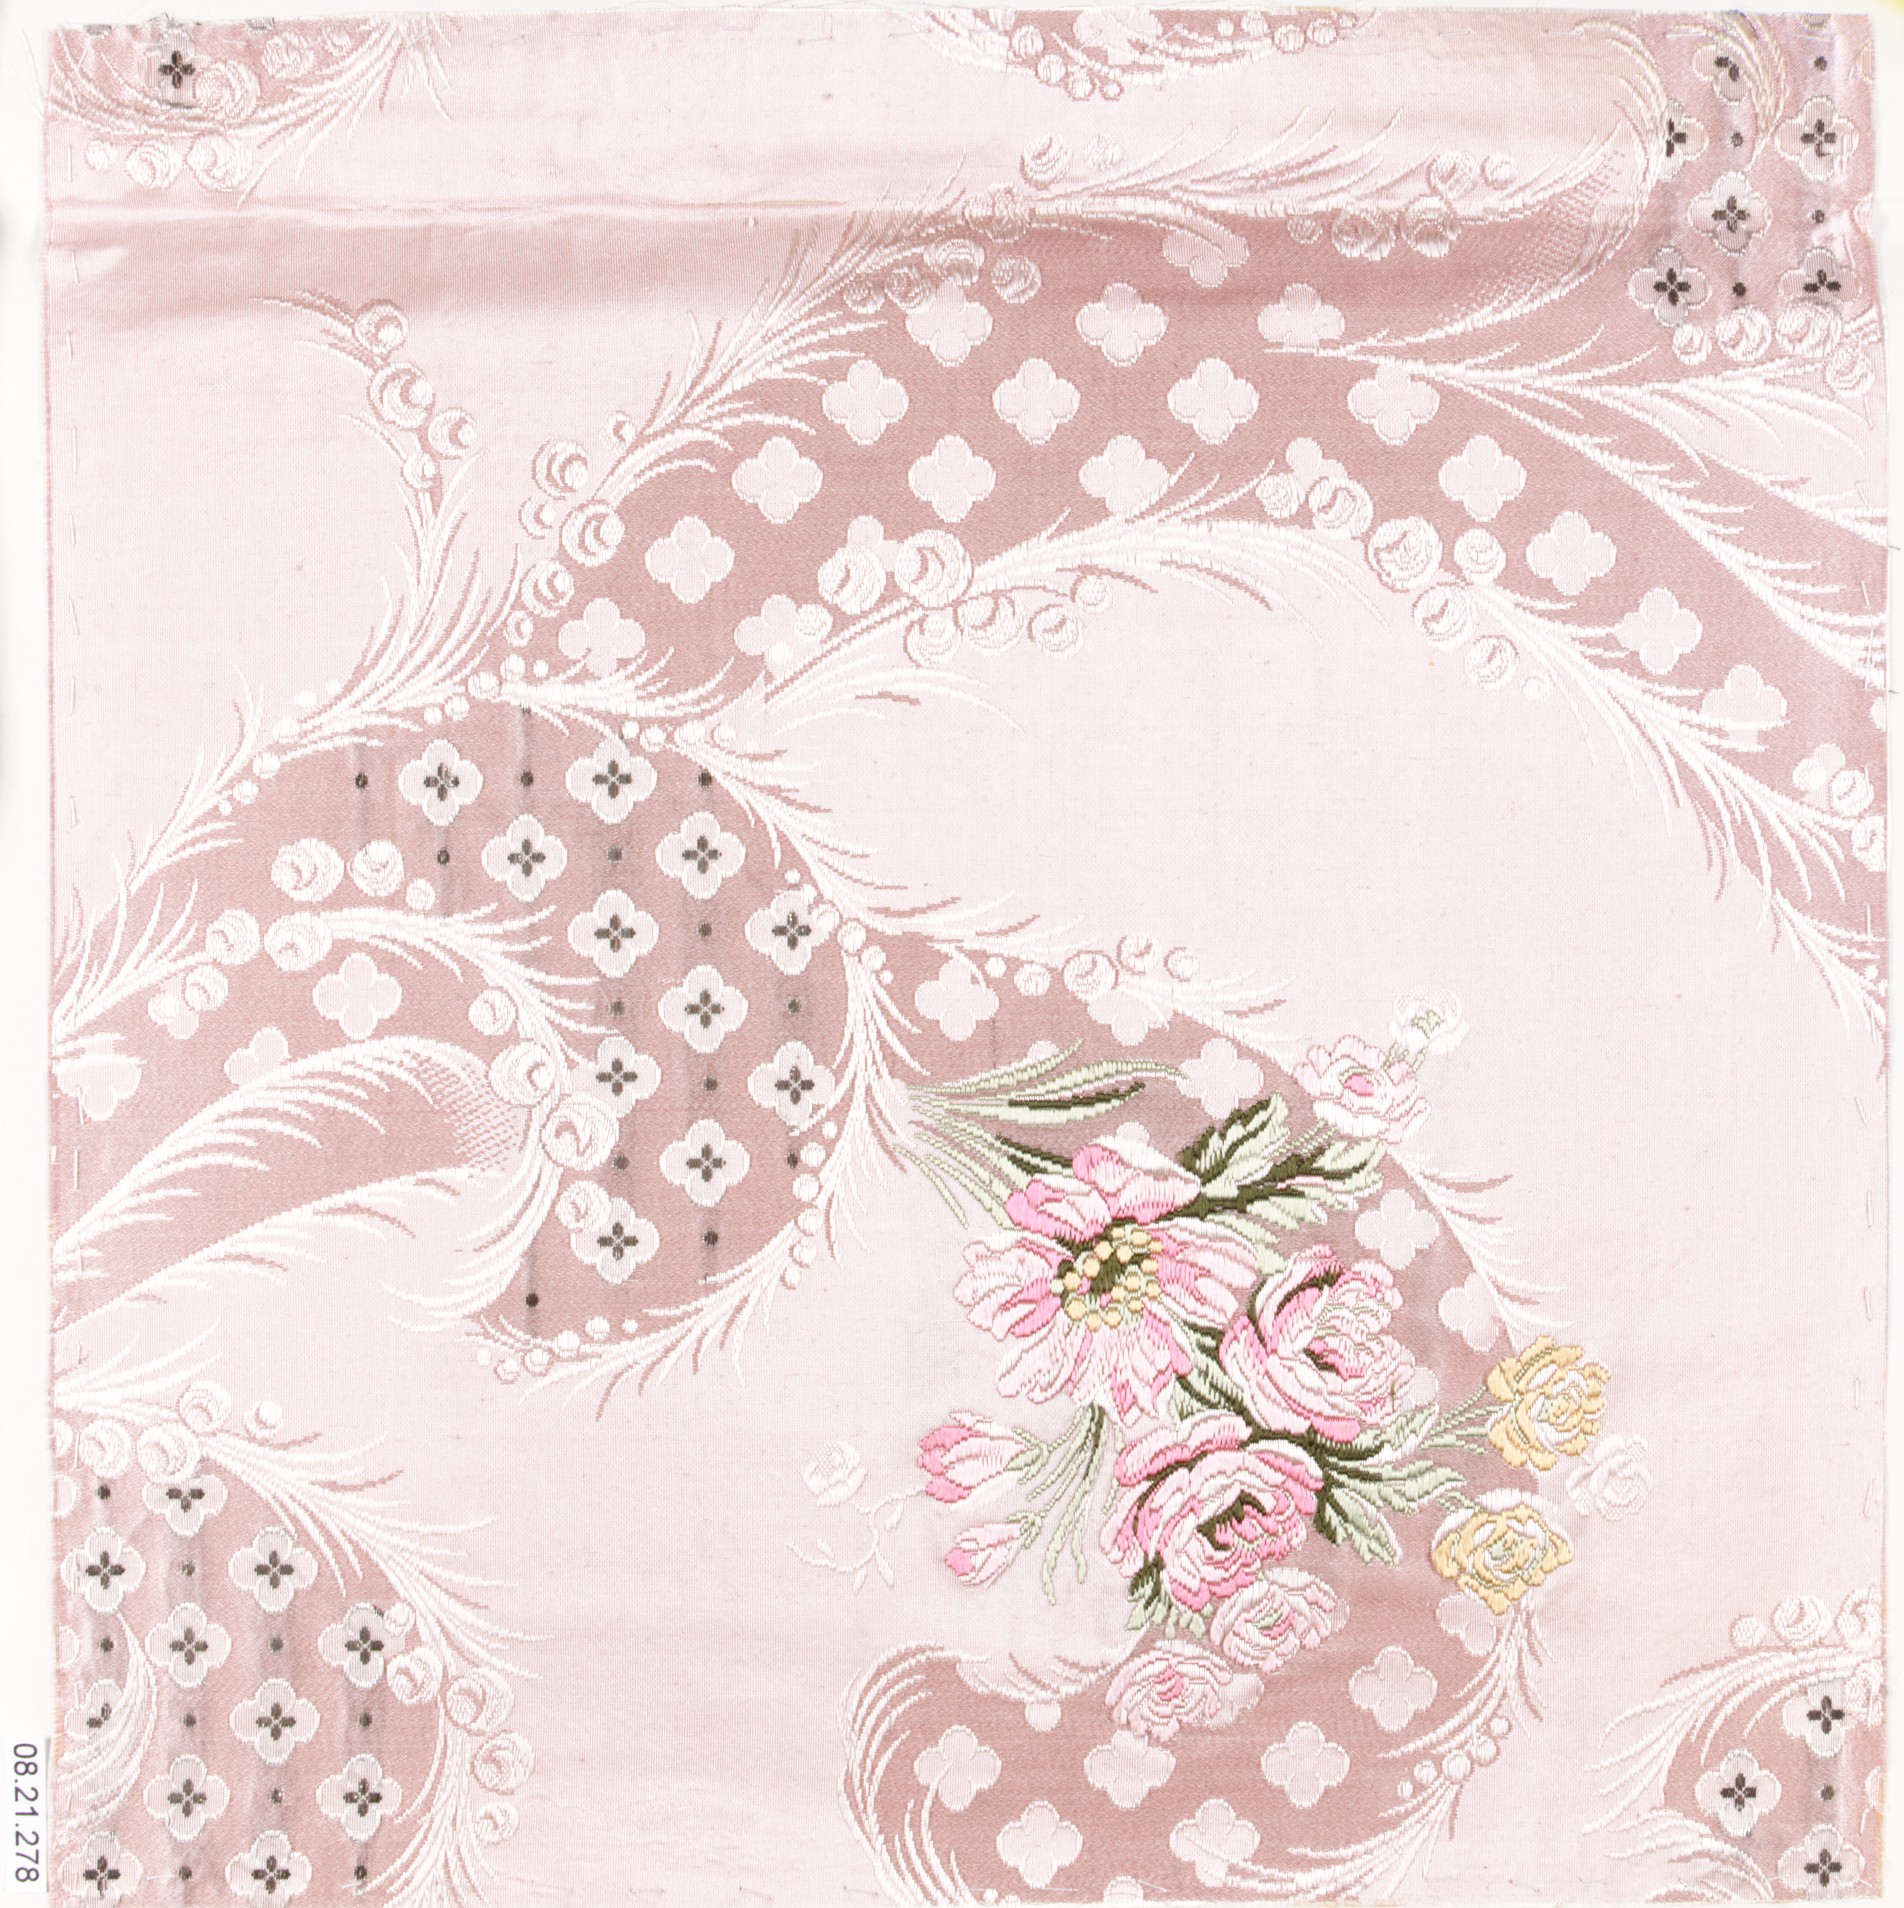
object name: textile sample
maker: Anonymous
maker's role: designer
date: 1900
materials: silk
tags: flowers